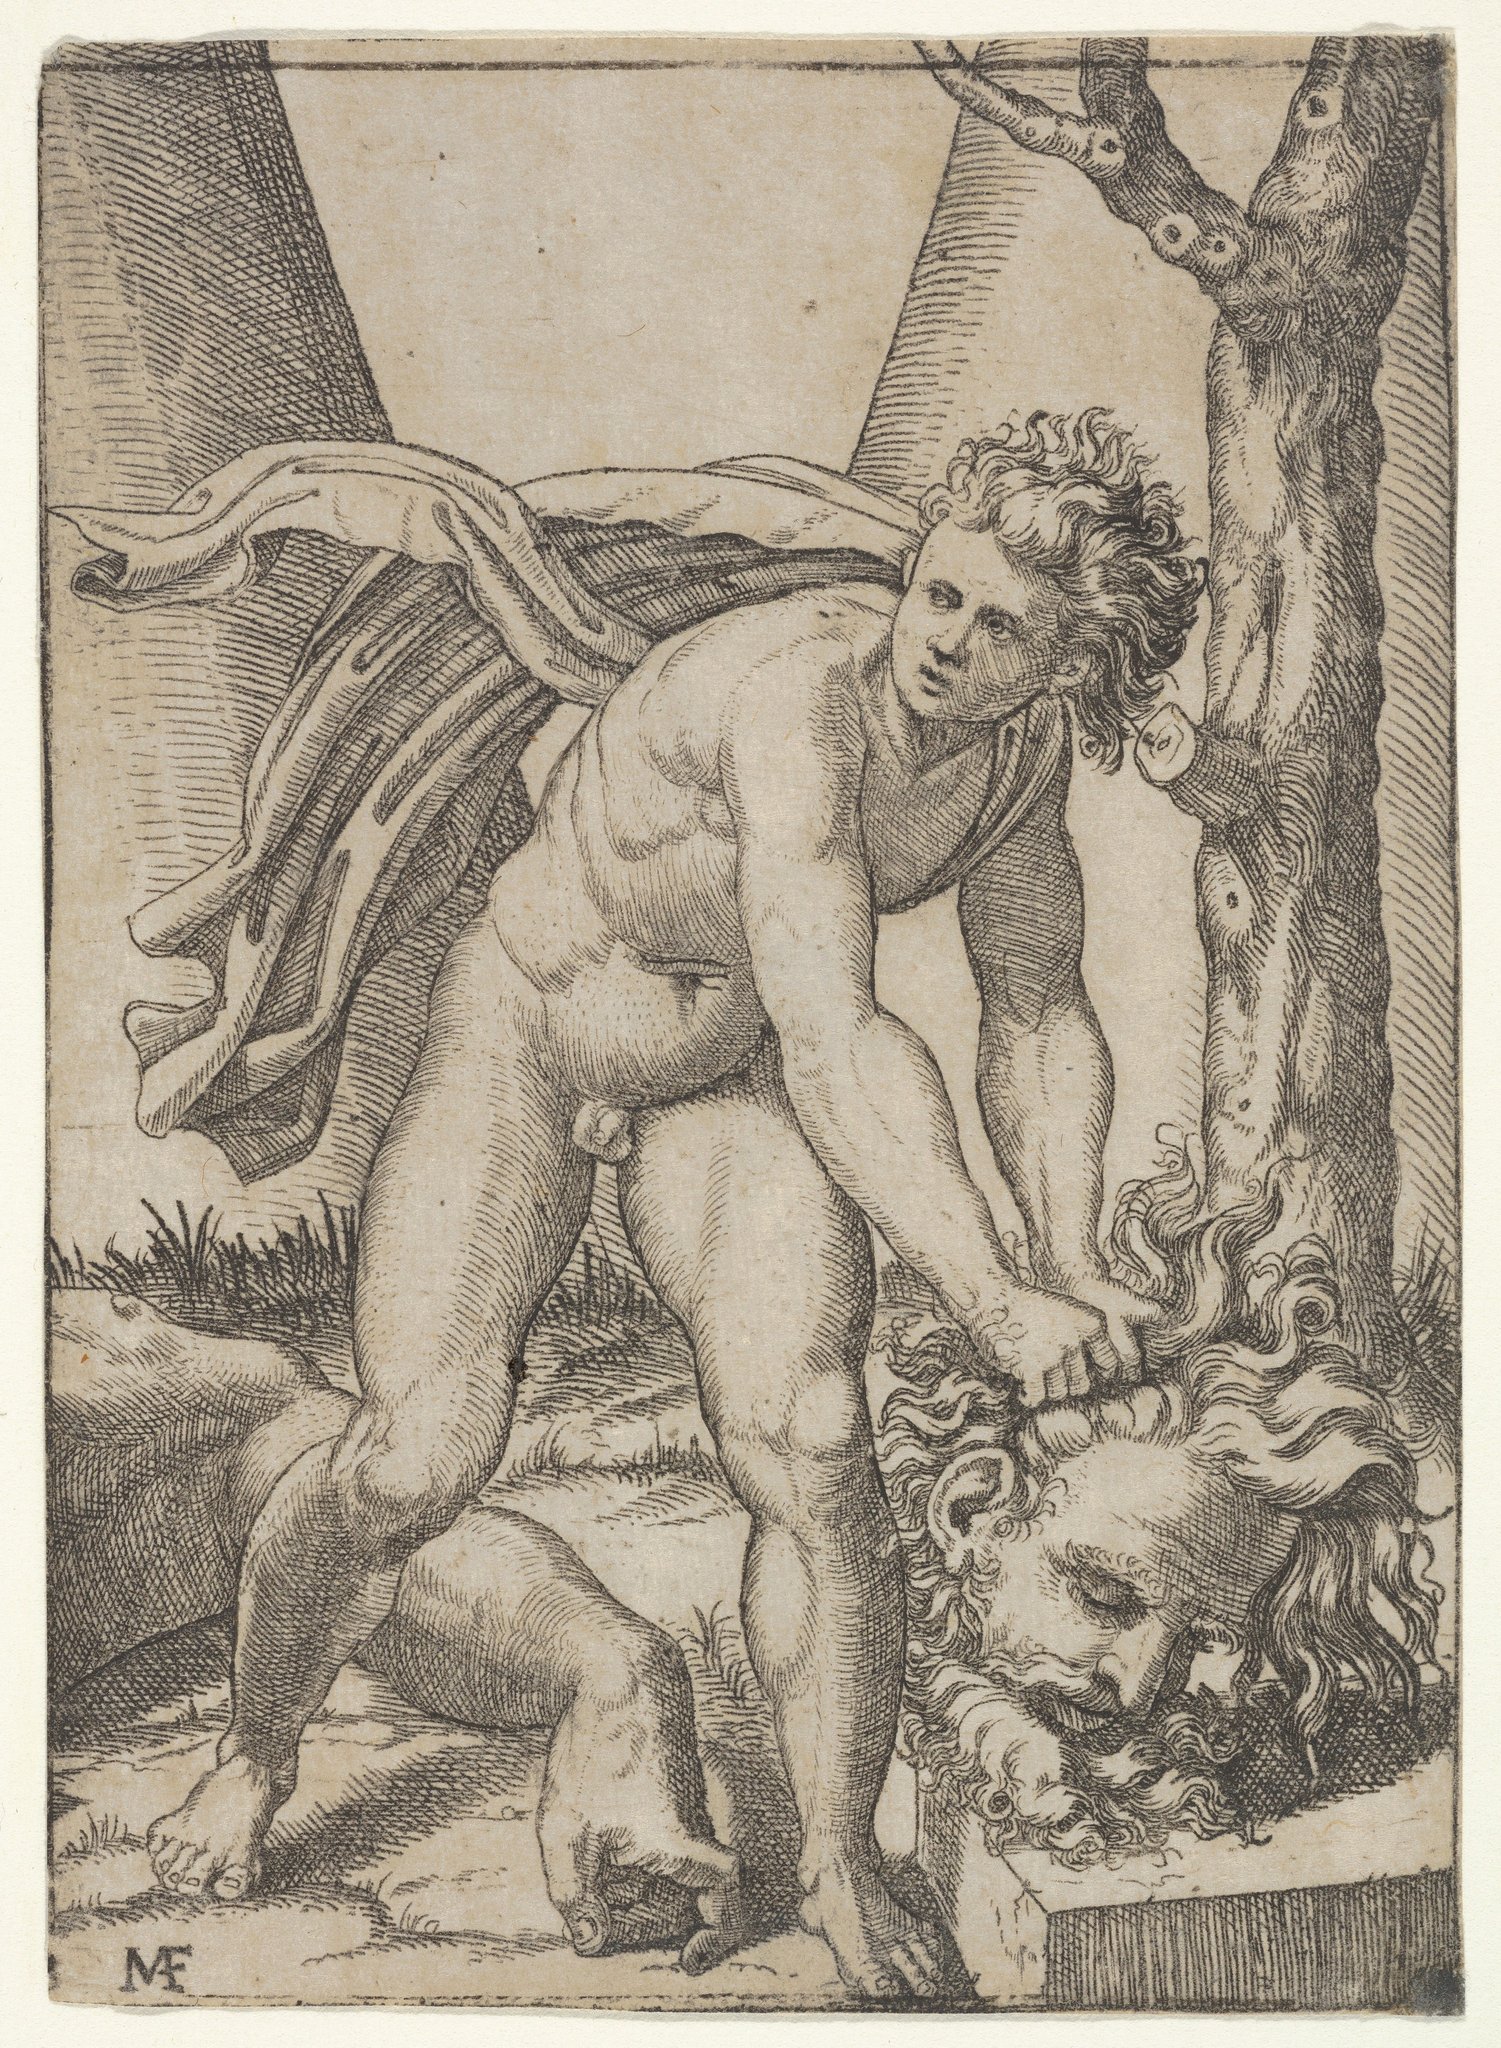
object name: print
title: David with the head of Goliath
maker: marcantonio raimondi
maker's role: artist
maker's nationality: italian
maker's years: 1475-1534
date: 1515-1516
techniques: engraving, etching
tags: heads,david